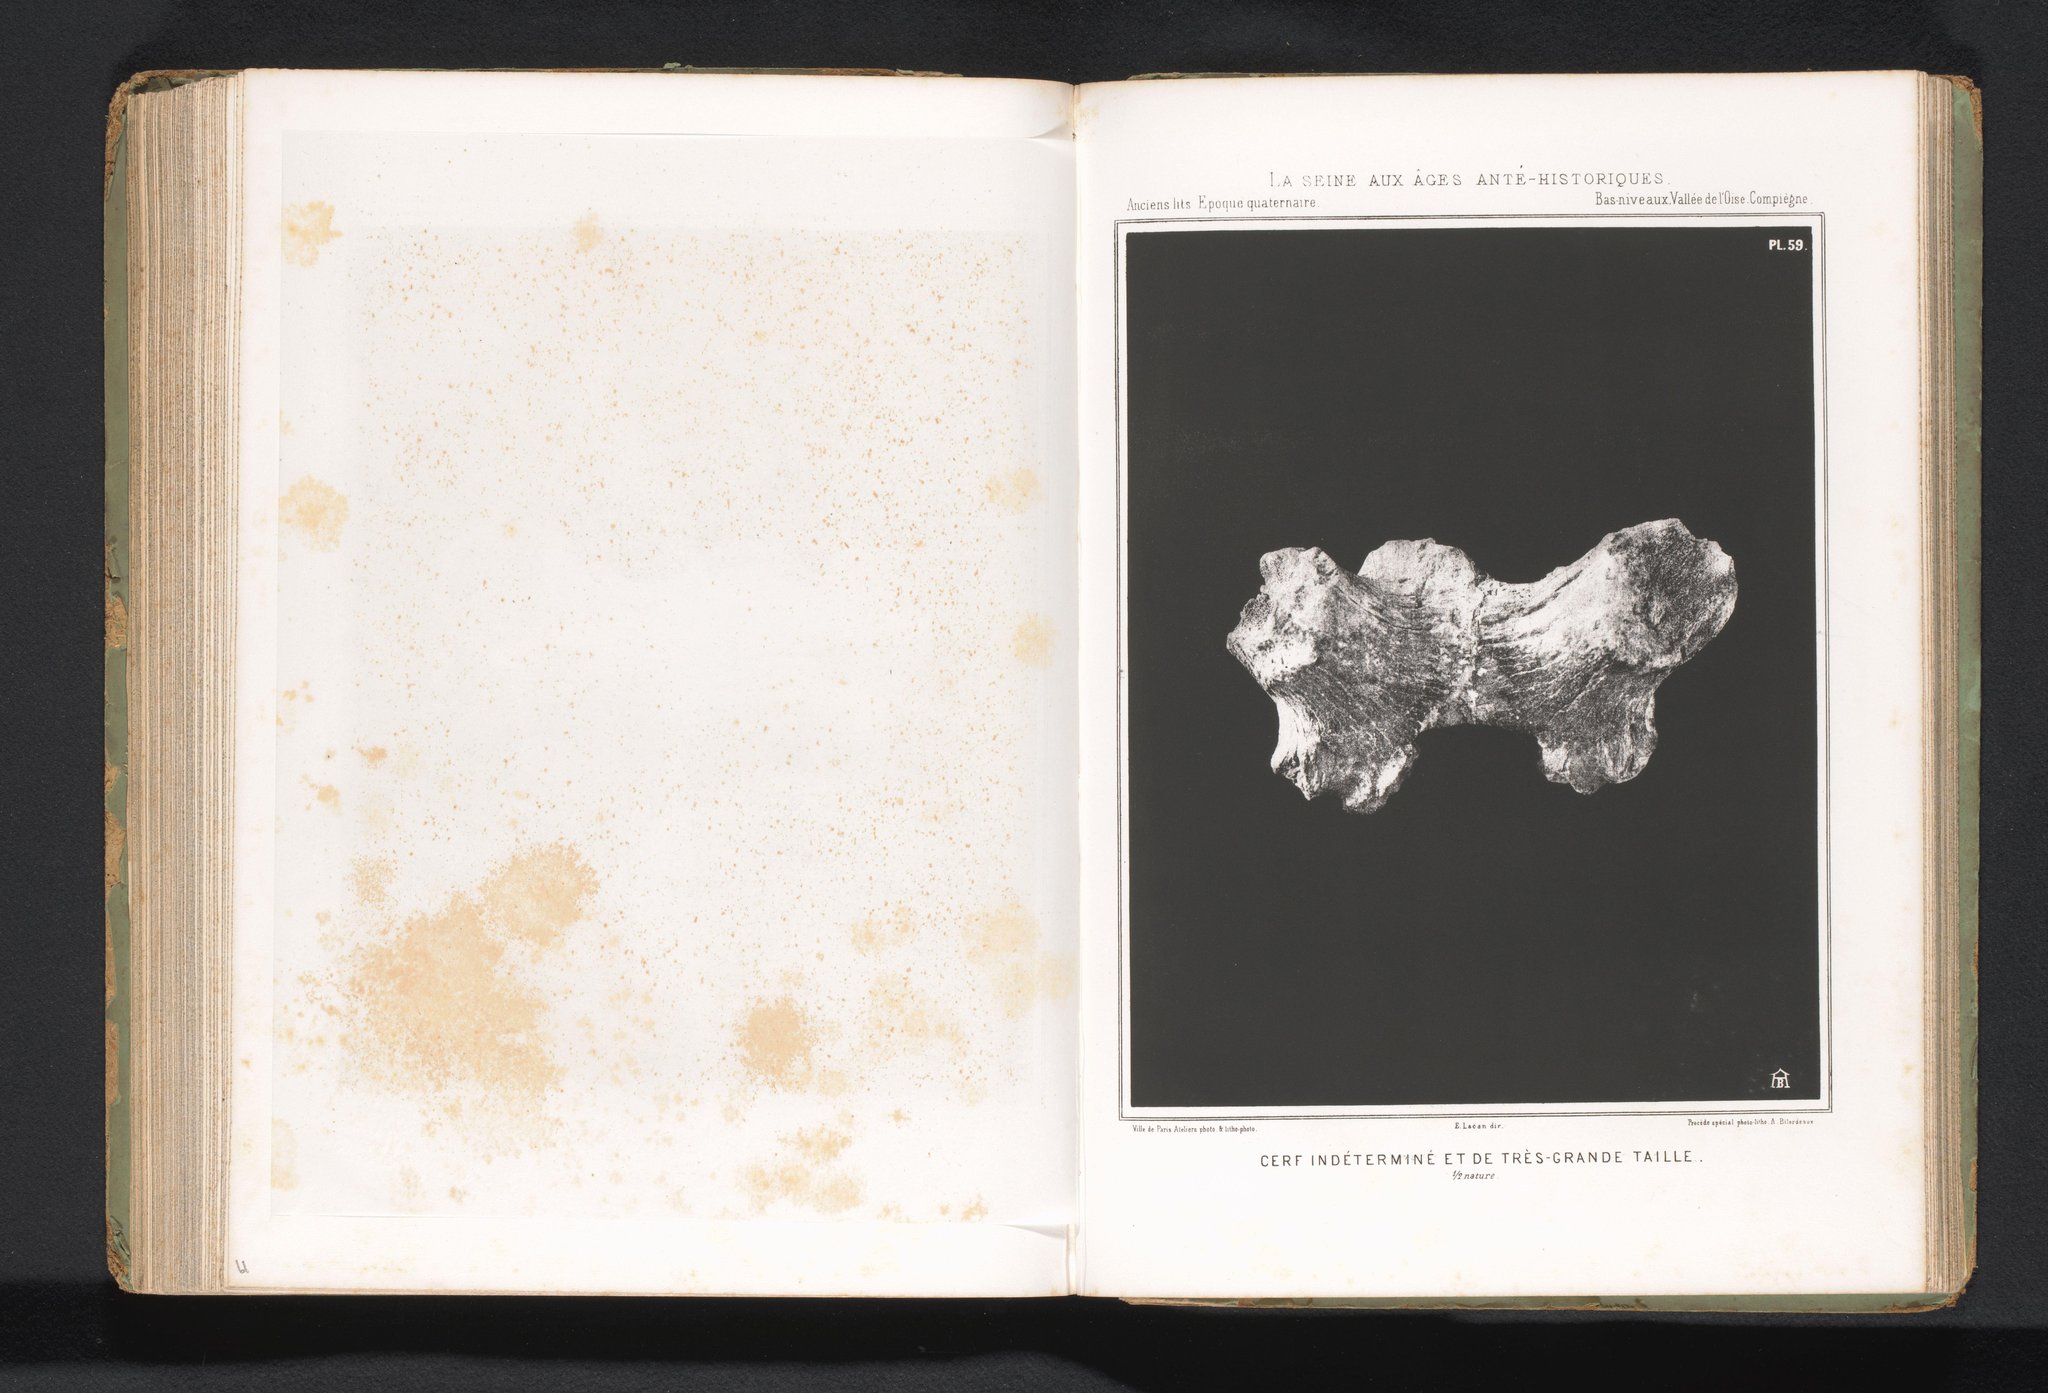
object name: photomechanical print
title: Cerft indéterminé et de très-grande taille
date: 1864-1869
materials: paper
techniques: photolithography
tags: mammals (+ skeleton of an animal)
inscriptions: inscription: ‘PL. 59’, inscription: ‘Procédé spécial photo-litho. A. Bilordeaux’, monogram: ‘AB’, inscription: ‘1/2 nature’